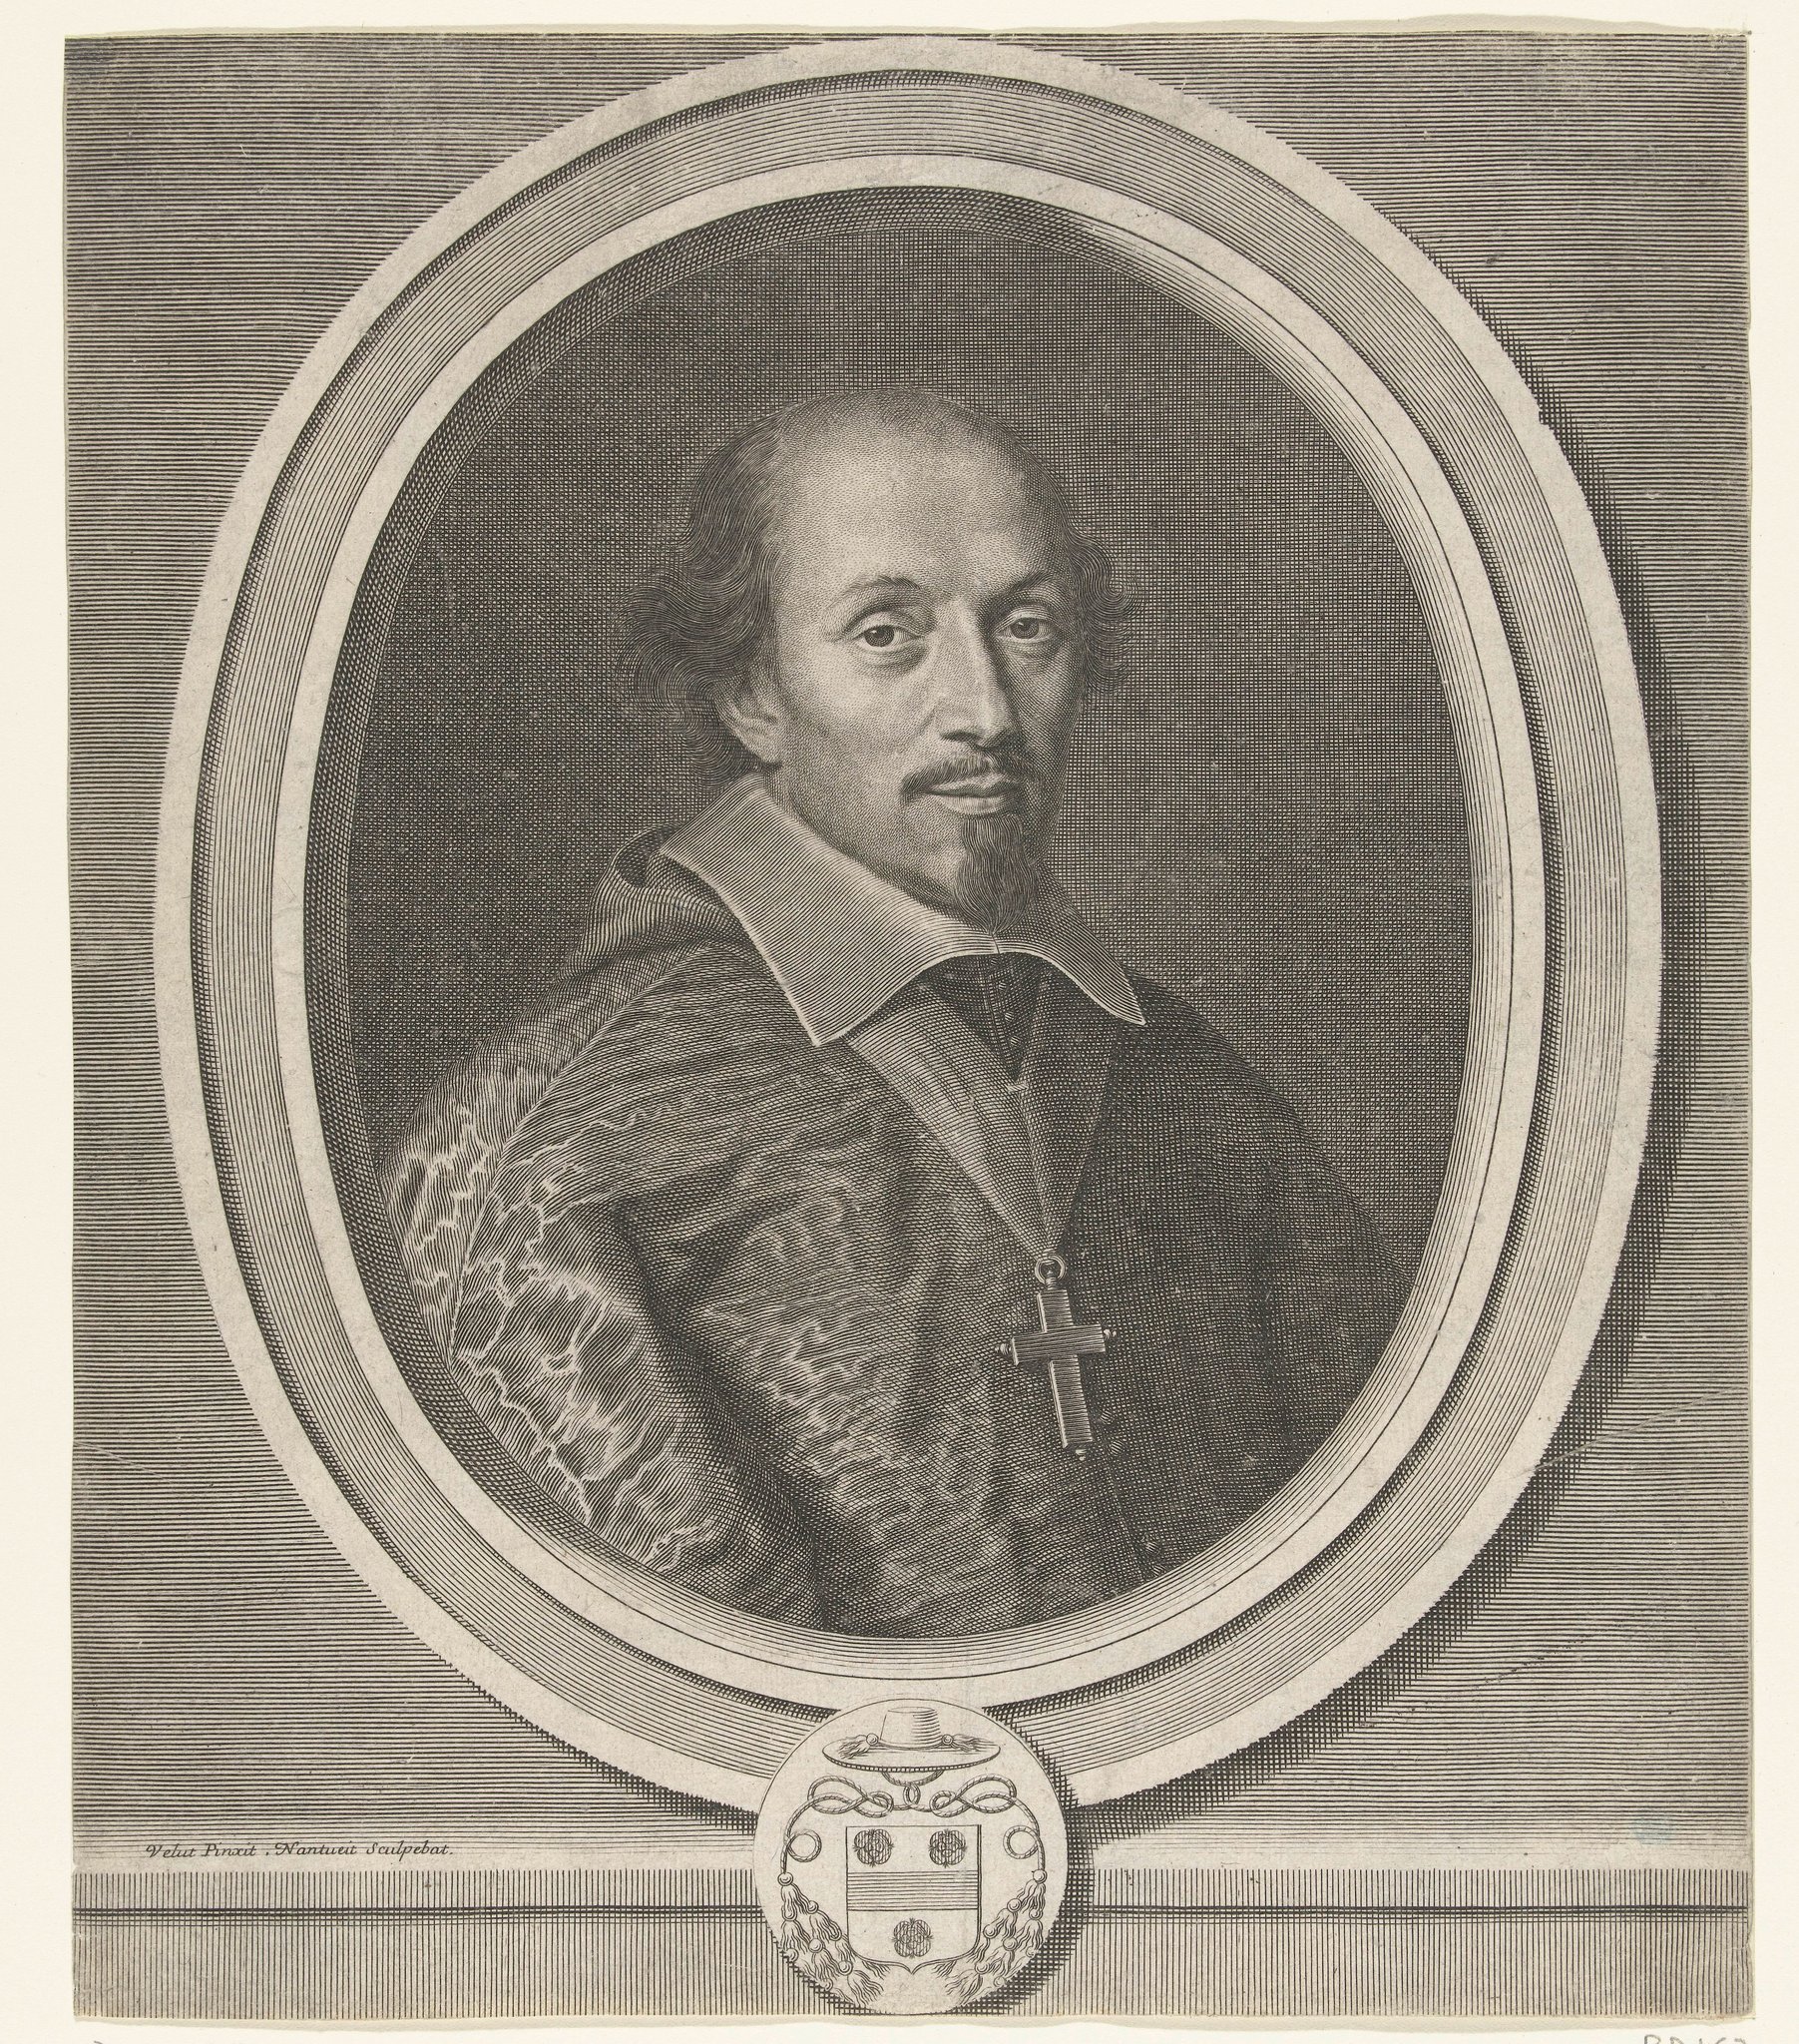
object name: print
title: Portret van François Mallier du Houssay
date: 1656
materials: paper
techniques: engraving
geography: france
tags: paris, priest, clergyman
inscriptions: collector's mark: Lugt 1337, collector's mark: Lugt 2228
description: Volgens Florent le Comte is de prent uit 1657. In de collectie van P. Mariette wordt de prent echter vermeld als zijnde uit 1656. Deze laatste datering wordt overgenomen door Petitjean en Wickert, omdat het zeer zeldzaam is om de spelling 'Nantueil' te vinden op een prent van na 1656. (zie petitjean & Wickert, 1925, p. 285) Botke, K.